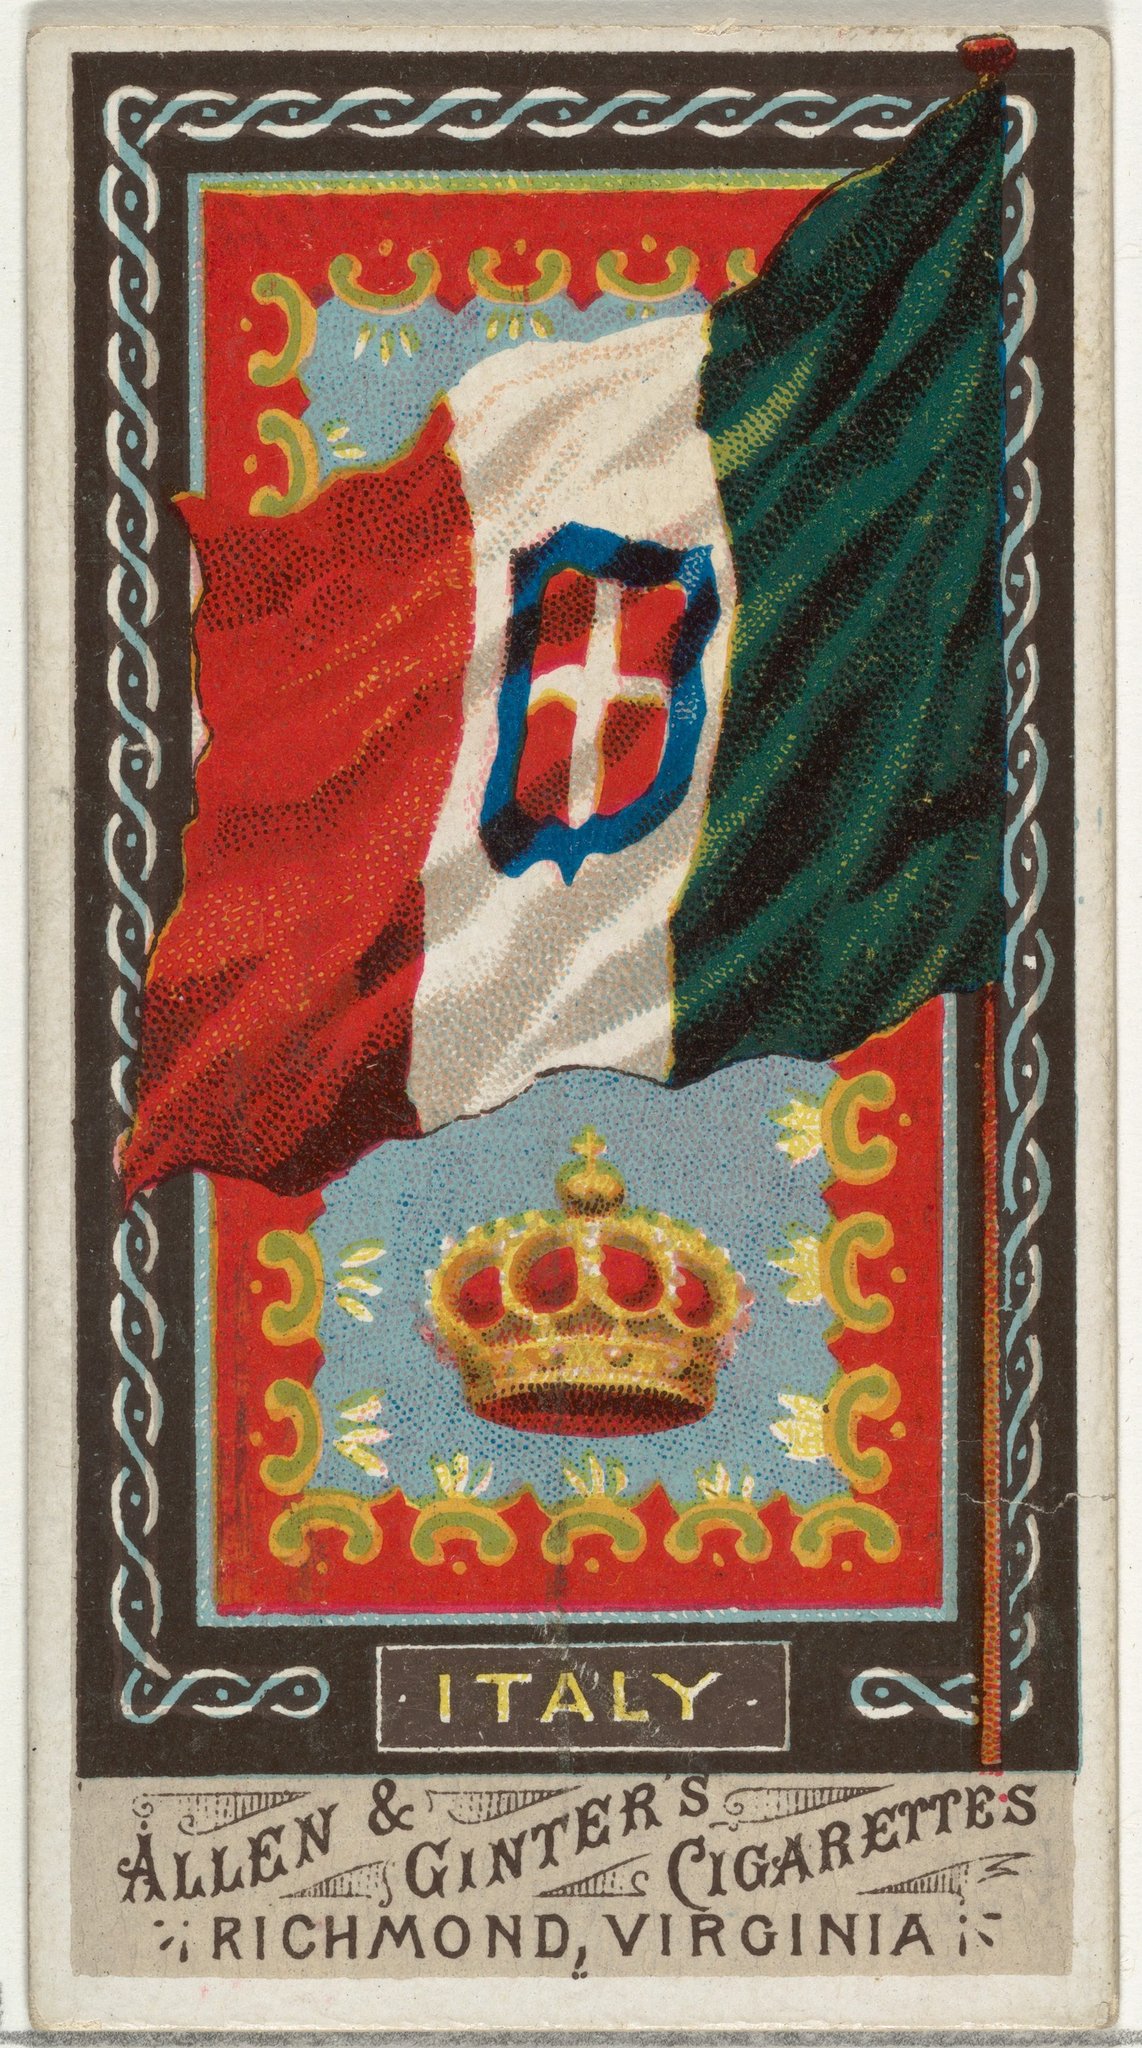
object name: print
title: Italy, from Flags of All Nations, Series 1 (N9) for Allen & Ginter Cigarettes Brands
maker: allen & ginter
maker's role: publisher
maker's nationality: american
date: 1887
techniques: color lithograph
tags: flags